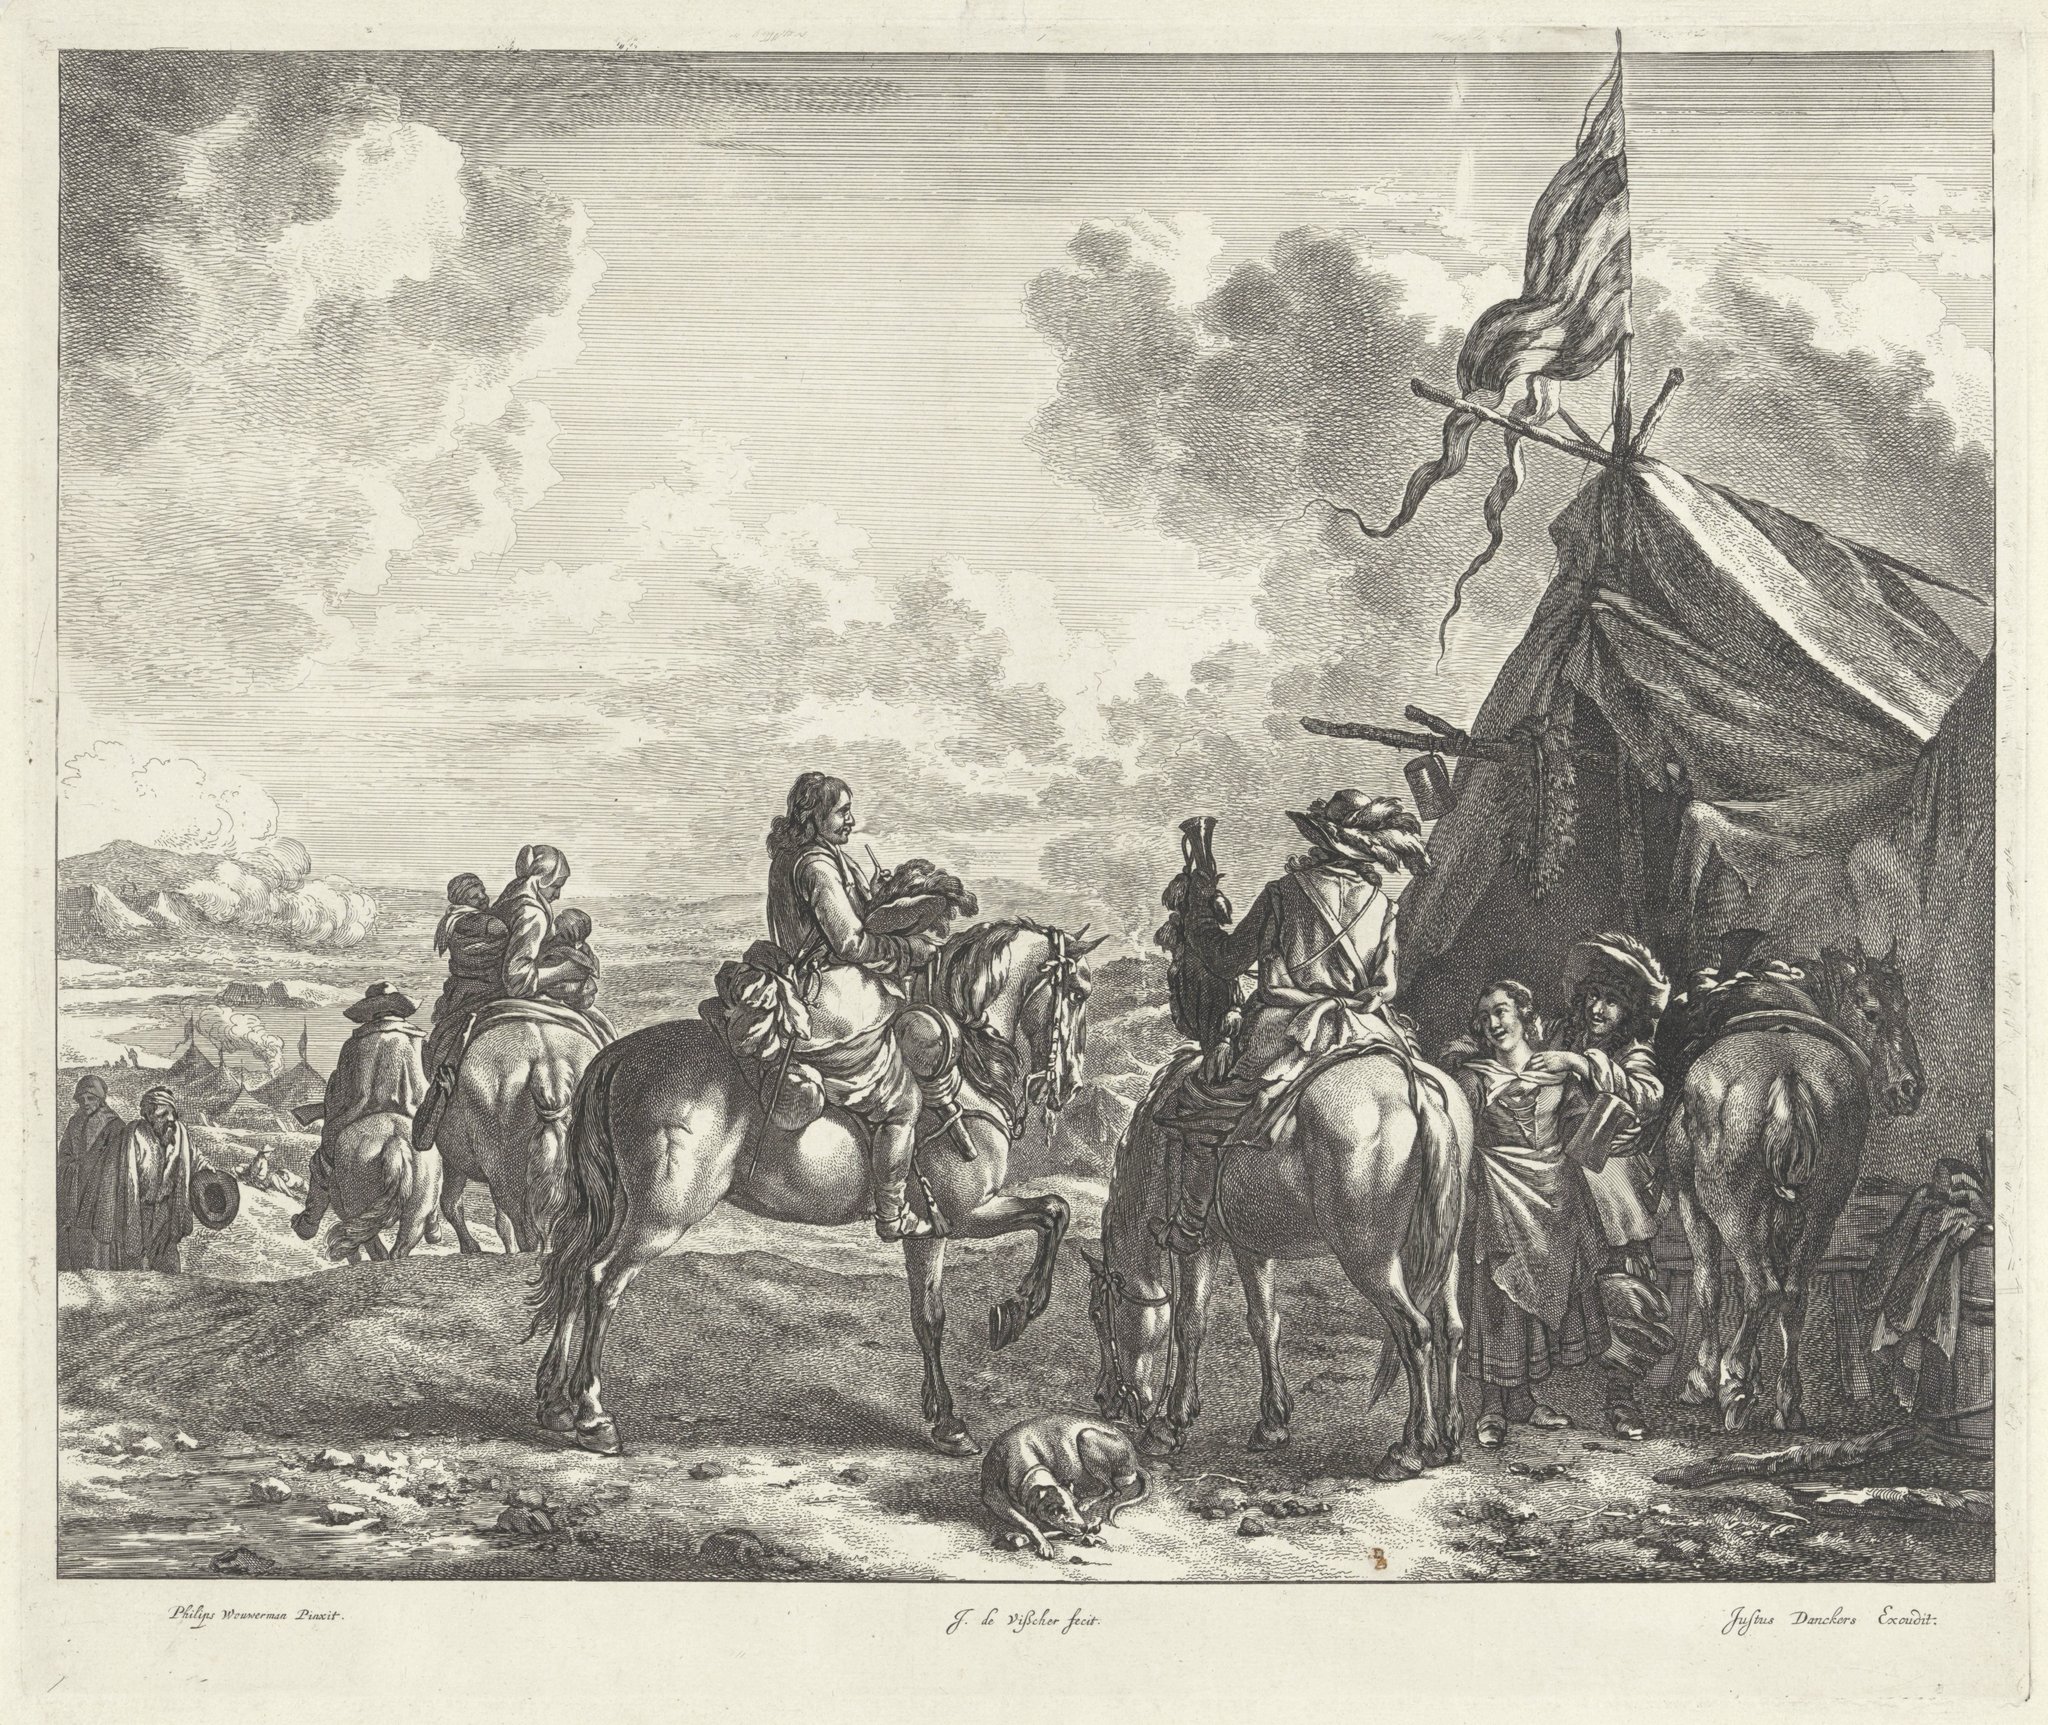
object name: print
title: Rustende soldaten bij tenten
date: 1643-1701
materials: paper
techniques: engraving, etching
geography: amsterdam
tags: riding a horse, ass, or mule; rider, horseman, (military) camp with tents, landscapes, lovers; courting, flirting, dog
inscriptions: collector's mark: Lugt 240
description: Soldaten met paarden voor een met een vaandel, een pul en een krans versierde tent in een legerkamp. Een van de soldaten is van zijn paard gestegen en raakt de hals van een vrouw met een bierpul aan, zij lacht.